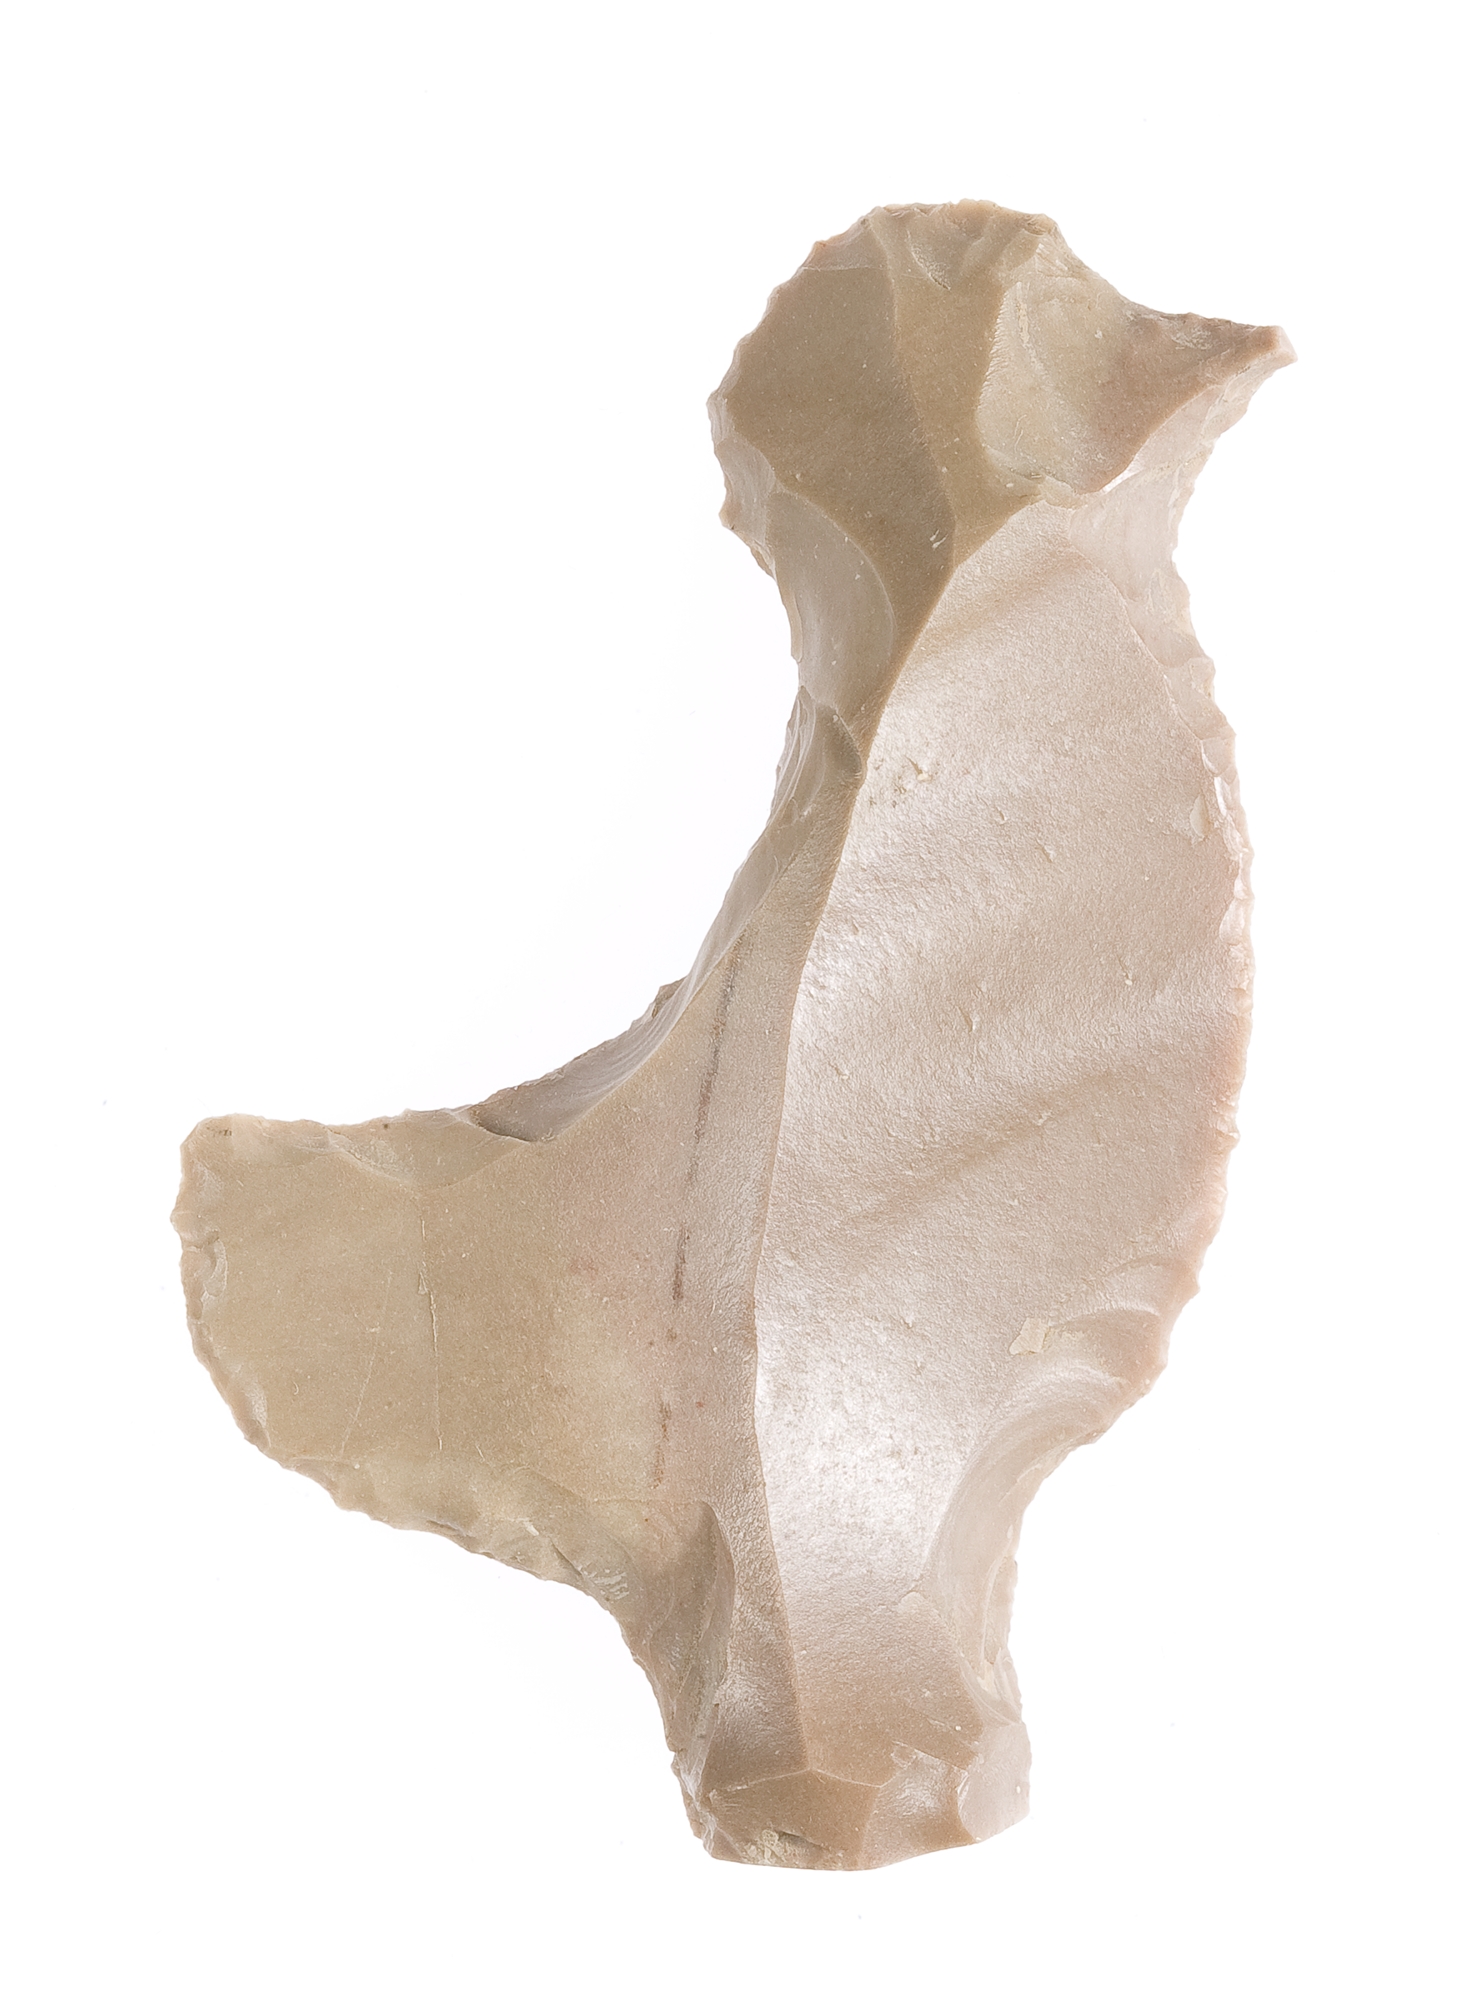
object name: eccentric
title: Flint shaped like a bird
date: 3300-2900 BCE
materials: stone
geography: egypt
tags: birds